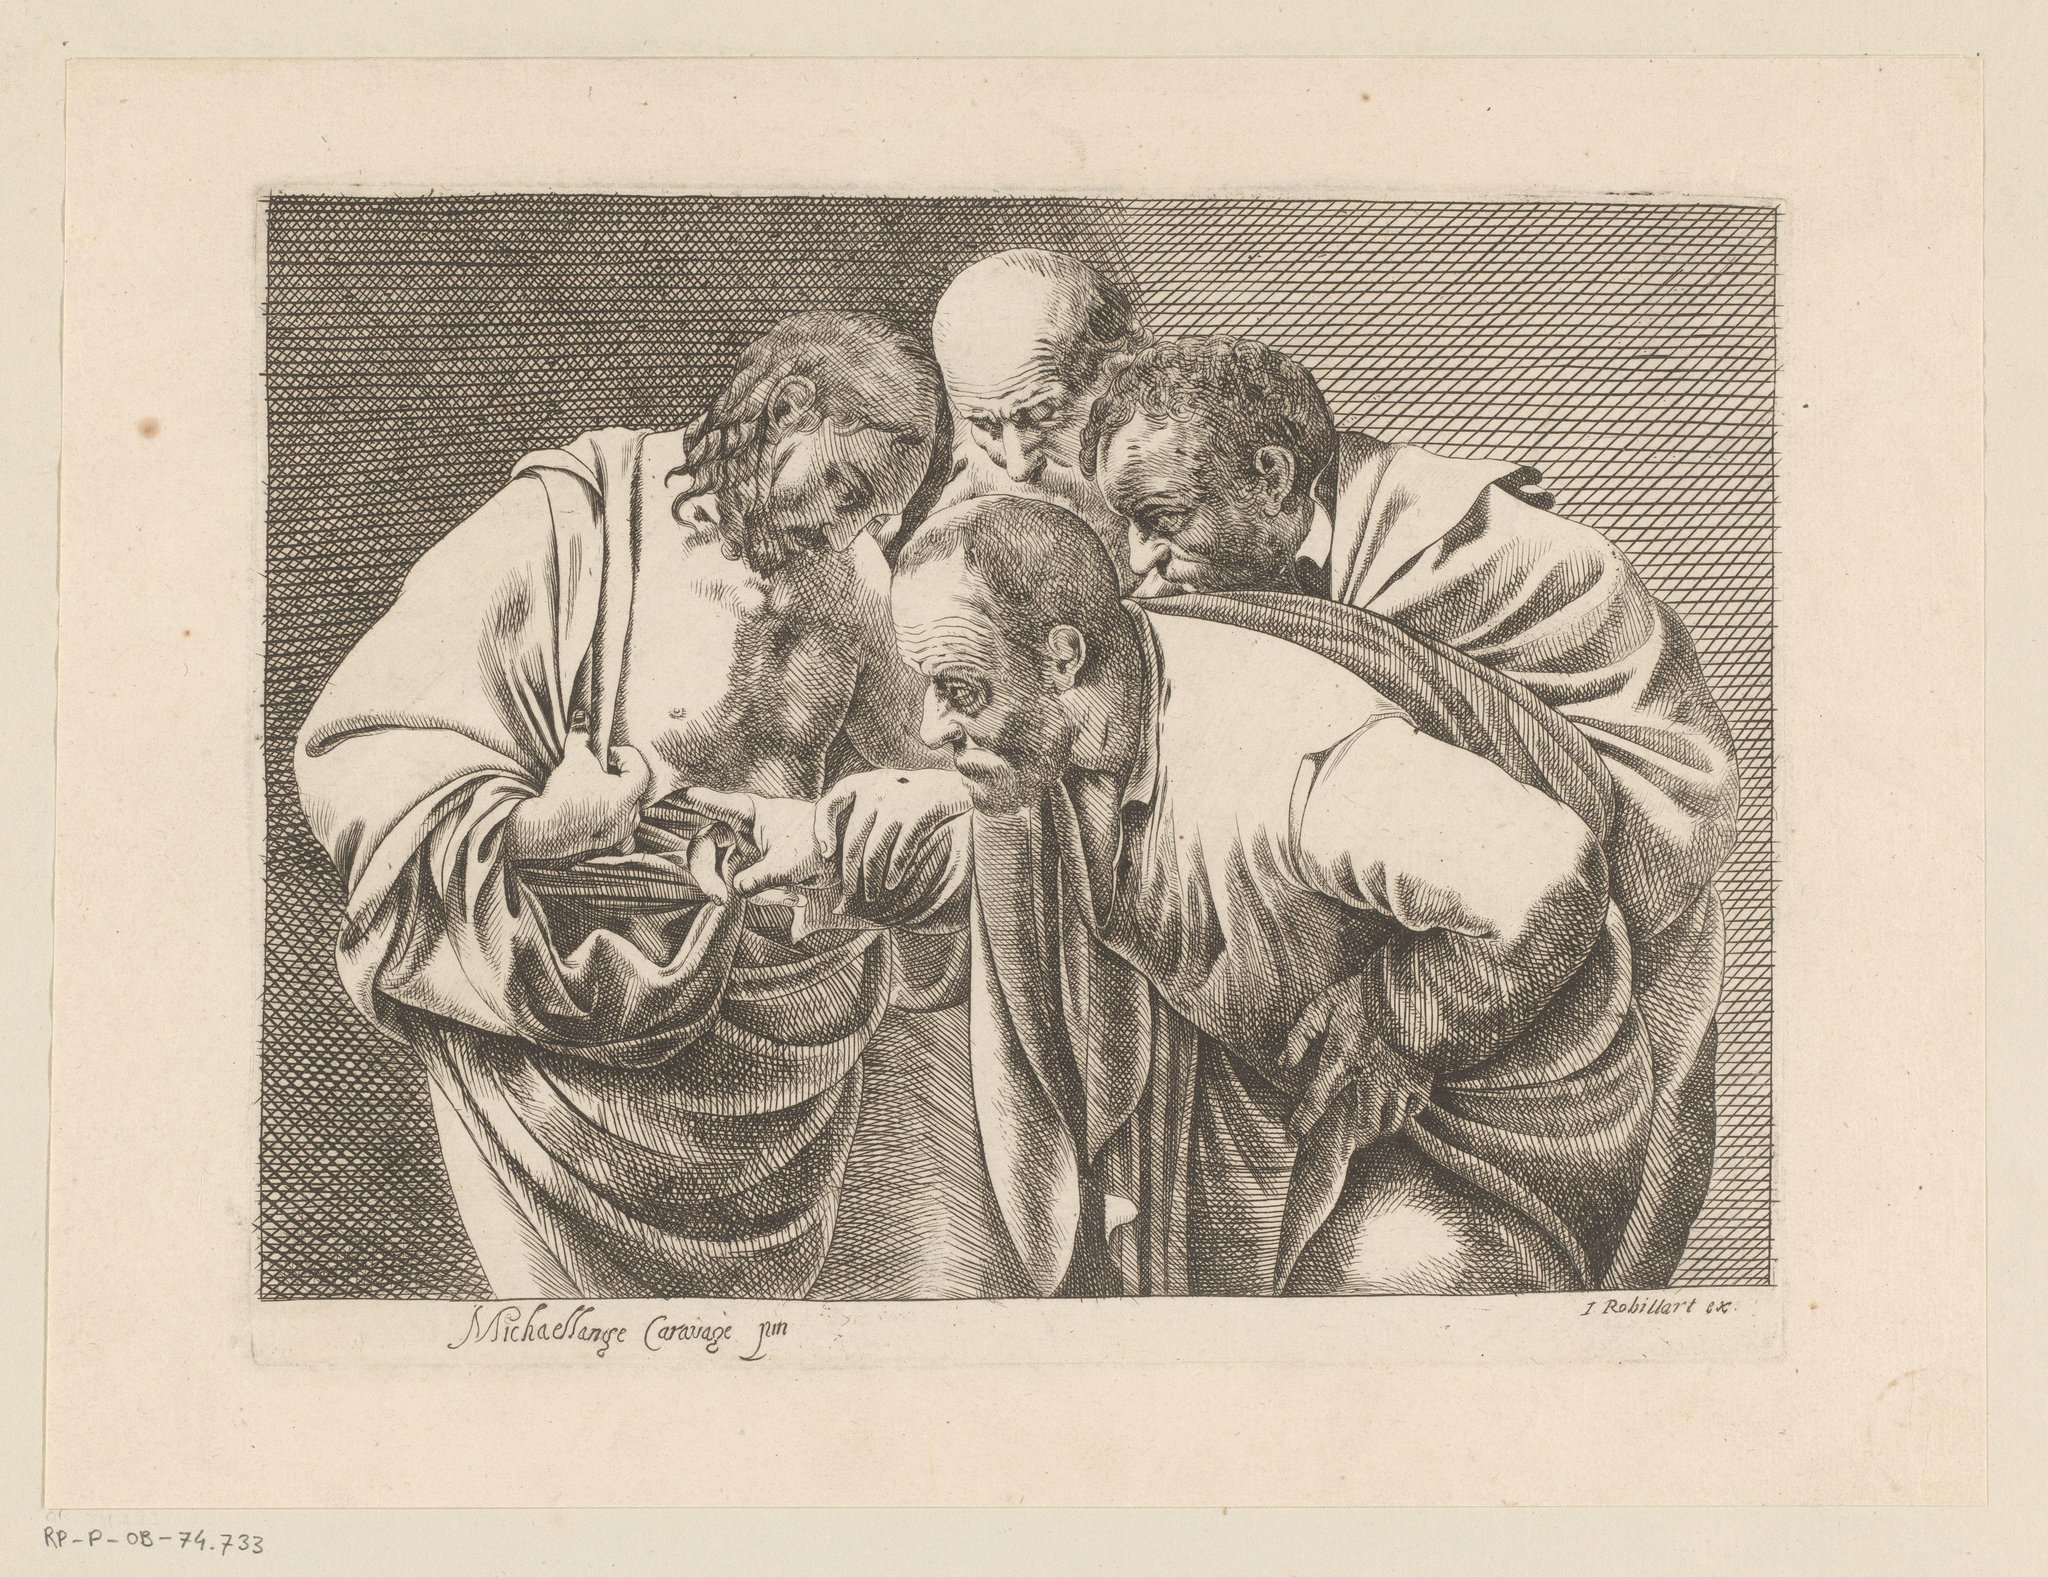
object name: print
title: Ongelovige Thomas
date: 1650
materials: paper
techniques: engraving, etching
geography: rome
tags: thomas touching or stretching out his hands to touch the wound in christ's side, sometimes christ leading thomas' hand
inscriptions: collector's mark: Lugt 240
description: Het schilderij door Caravaggio bevindt zich in de collectie van het Sanssouci te Potsdam.